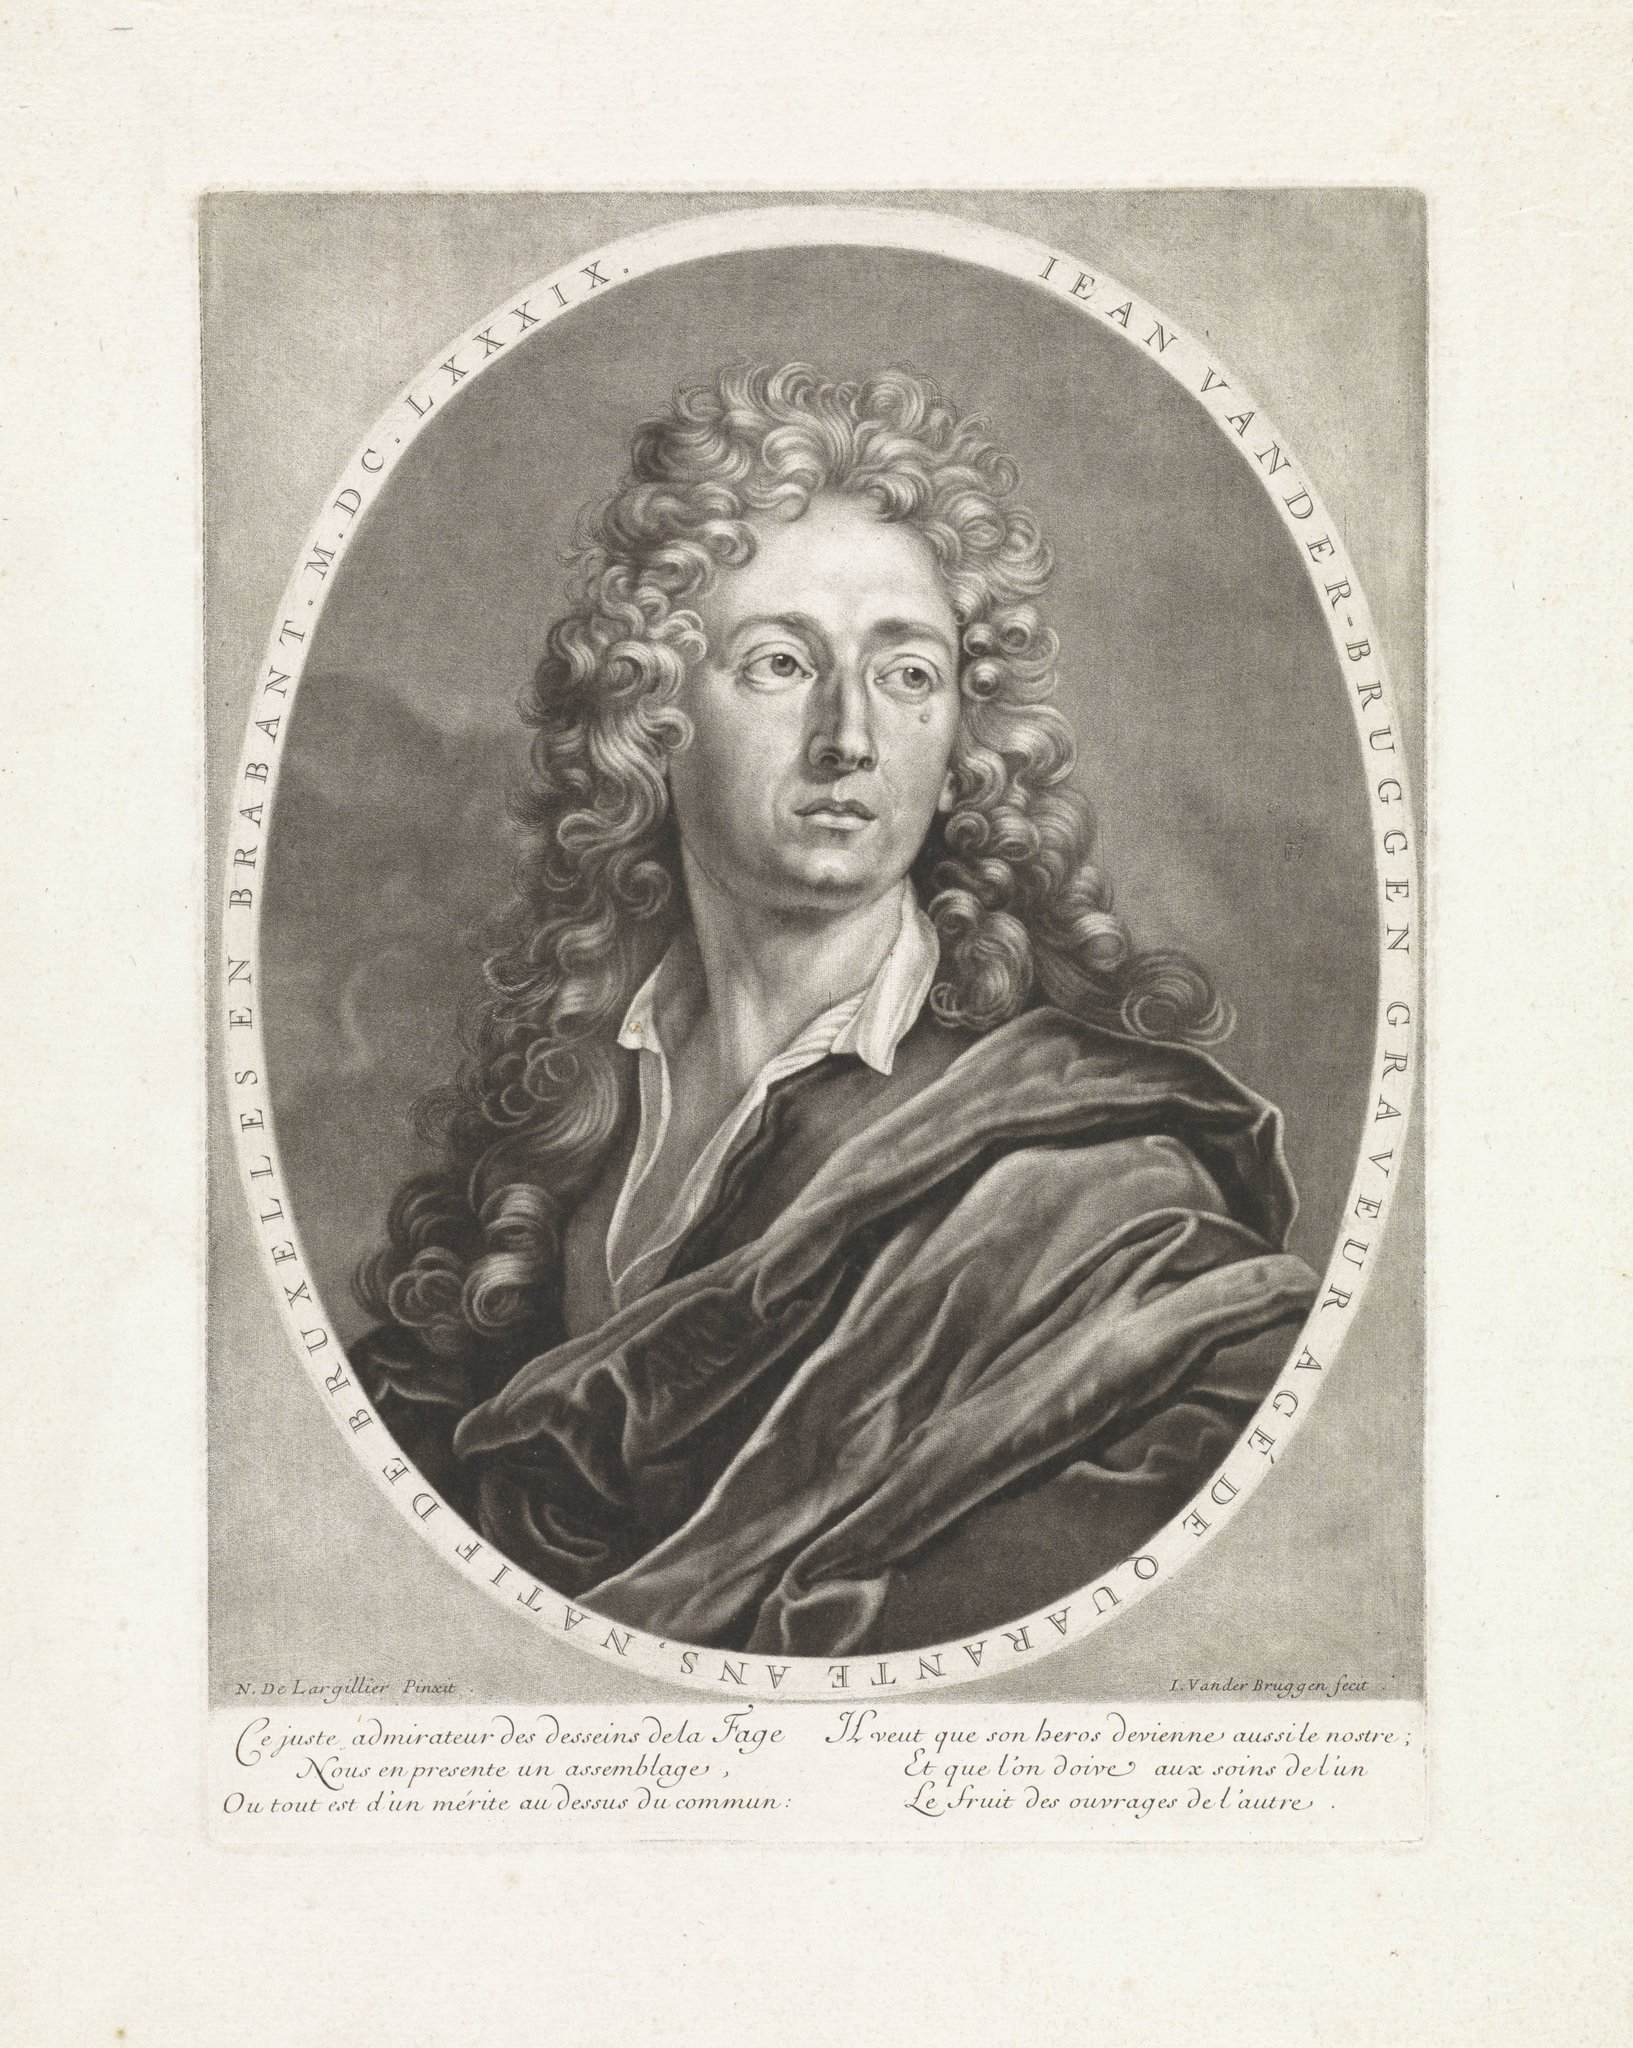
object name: print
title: Zelfportret van Jan van der Bruggen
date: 1689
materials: paper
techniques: engraving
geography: paris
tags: brussels, print maker, draughtsman, jan van der bruggen, portrait, self-portrait of artist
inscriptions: collector's mark: Lugt 2228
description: Zelfportret van de graveur en tekenaar Jan van der Bruggen, op 40-jarige leeftijd.